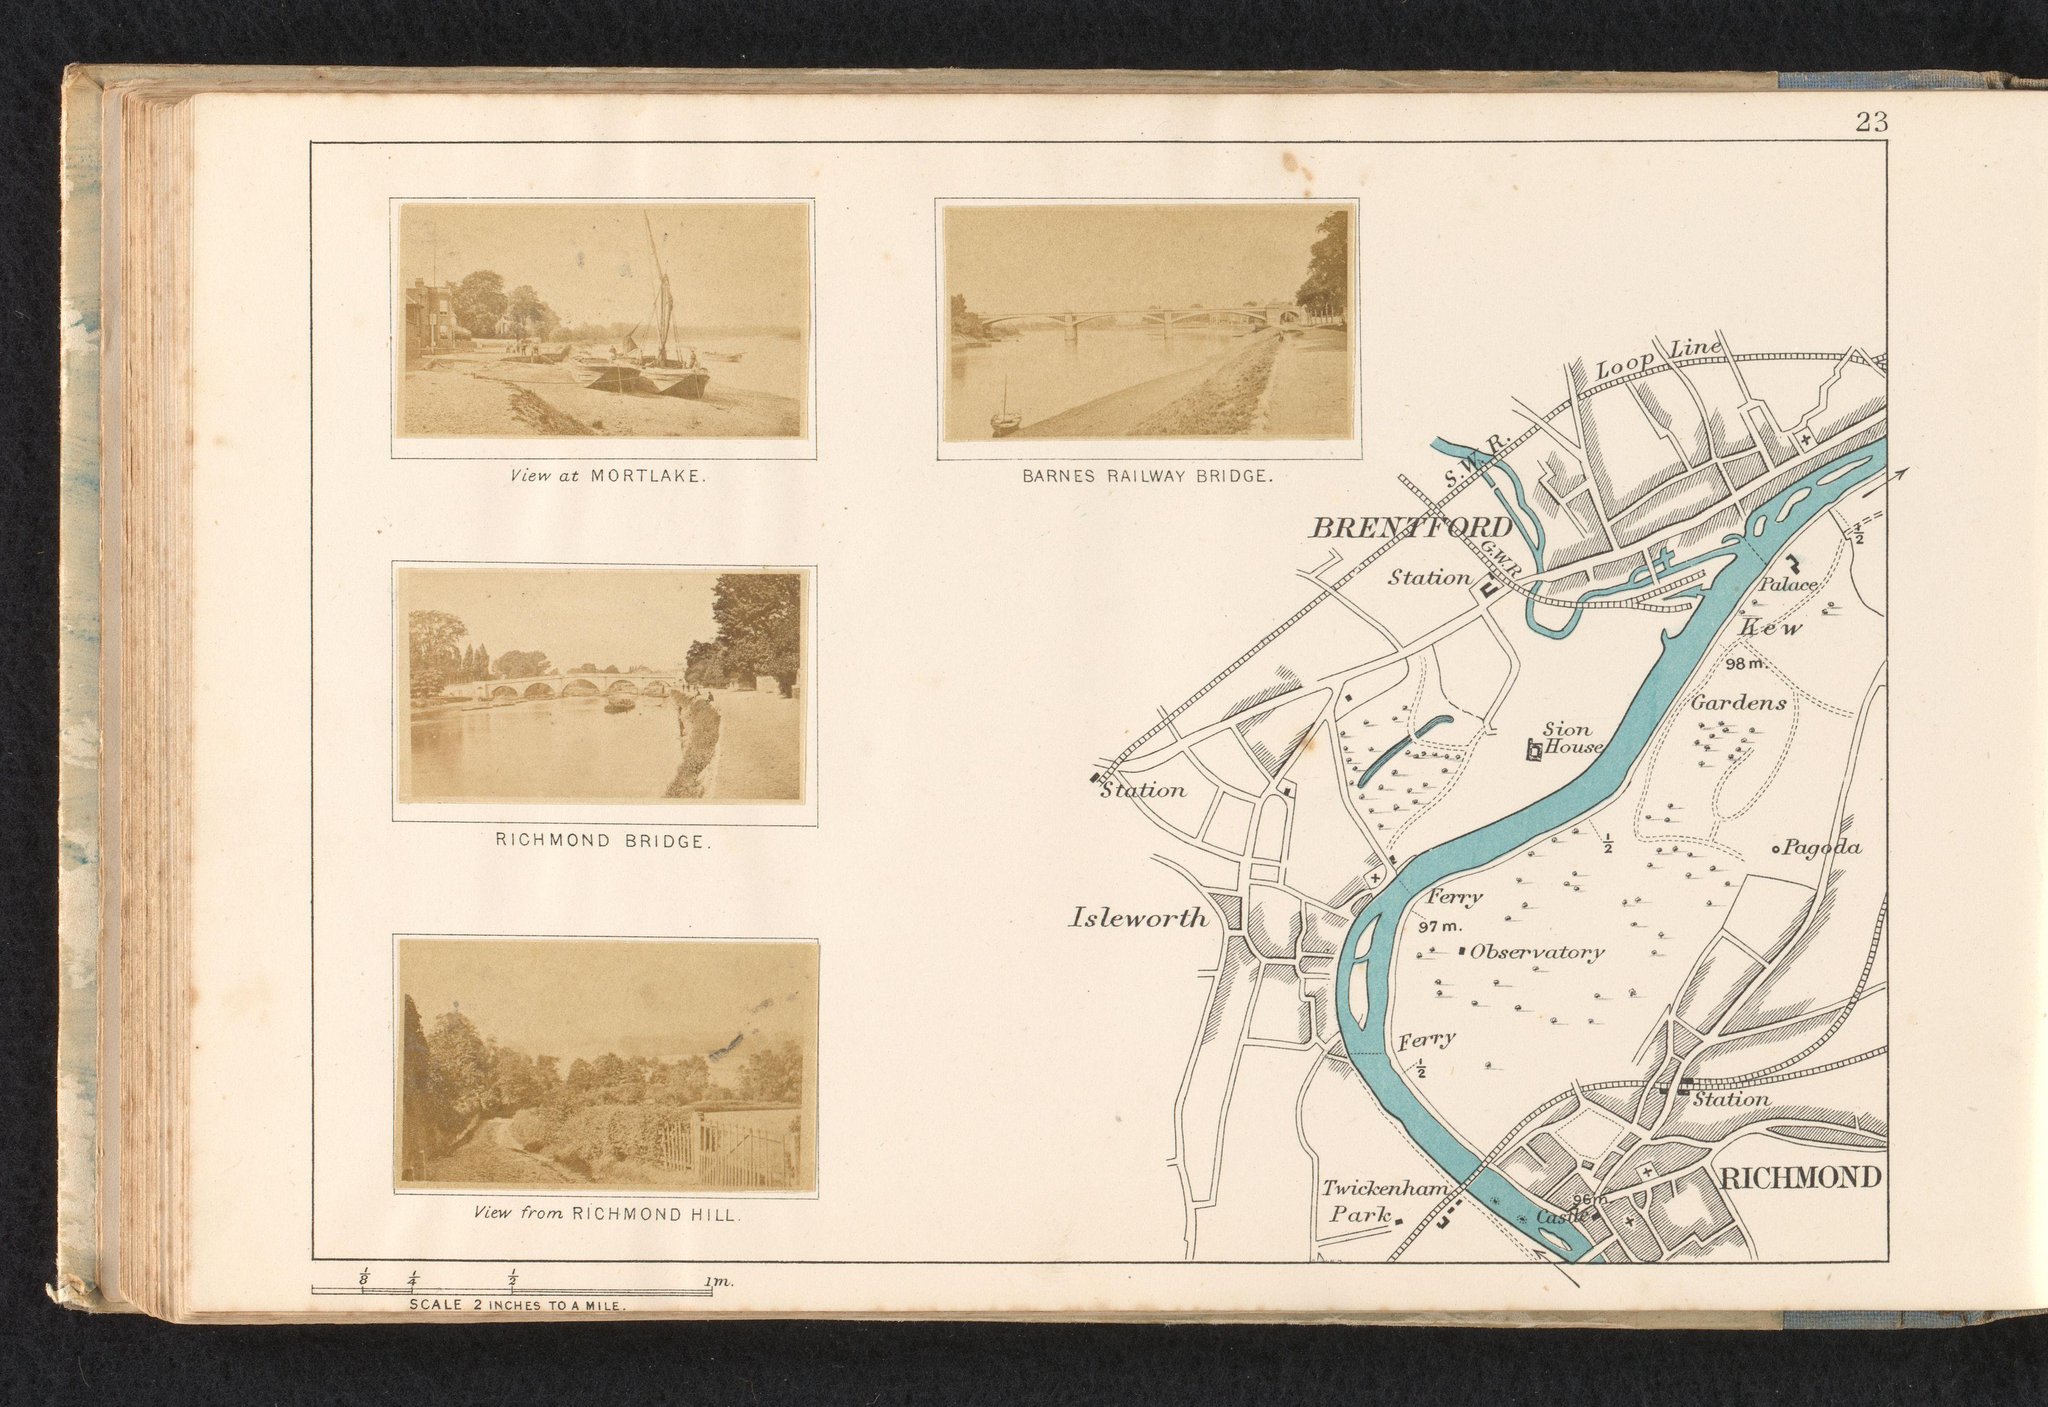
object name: photograph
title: Gezicht op rivierlandschap bij Mortlake, Richmond Railway Bridge, Richmond Bridge en gezicht op landschap vanaf de heuvel van Richmond upon Thames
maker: Anonymous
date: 1868-1873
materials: paper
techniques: albumen print, letterpress printing, line block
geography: greater london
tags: landscapes in the temperate zone, river bank, landscape with bridge, viaduct or aqueduct, (high) hill